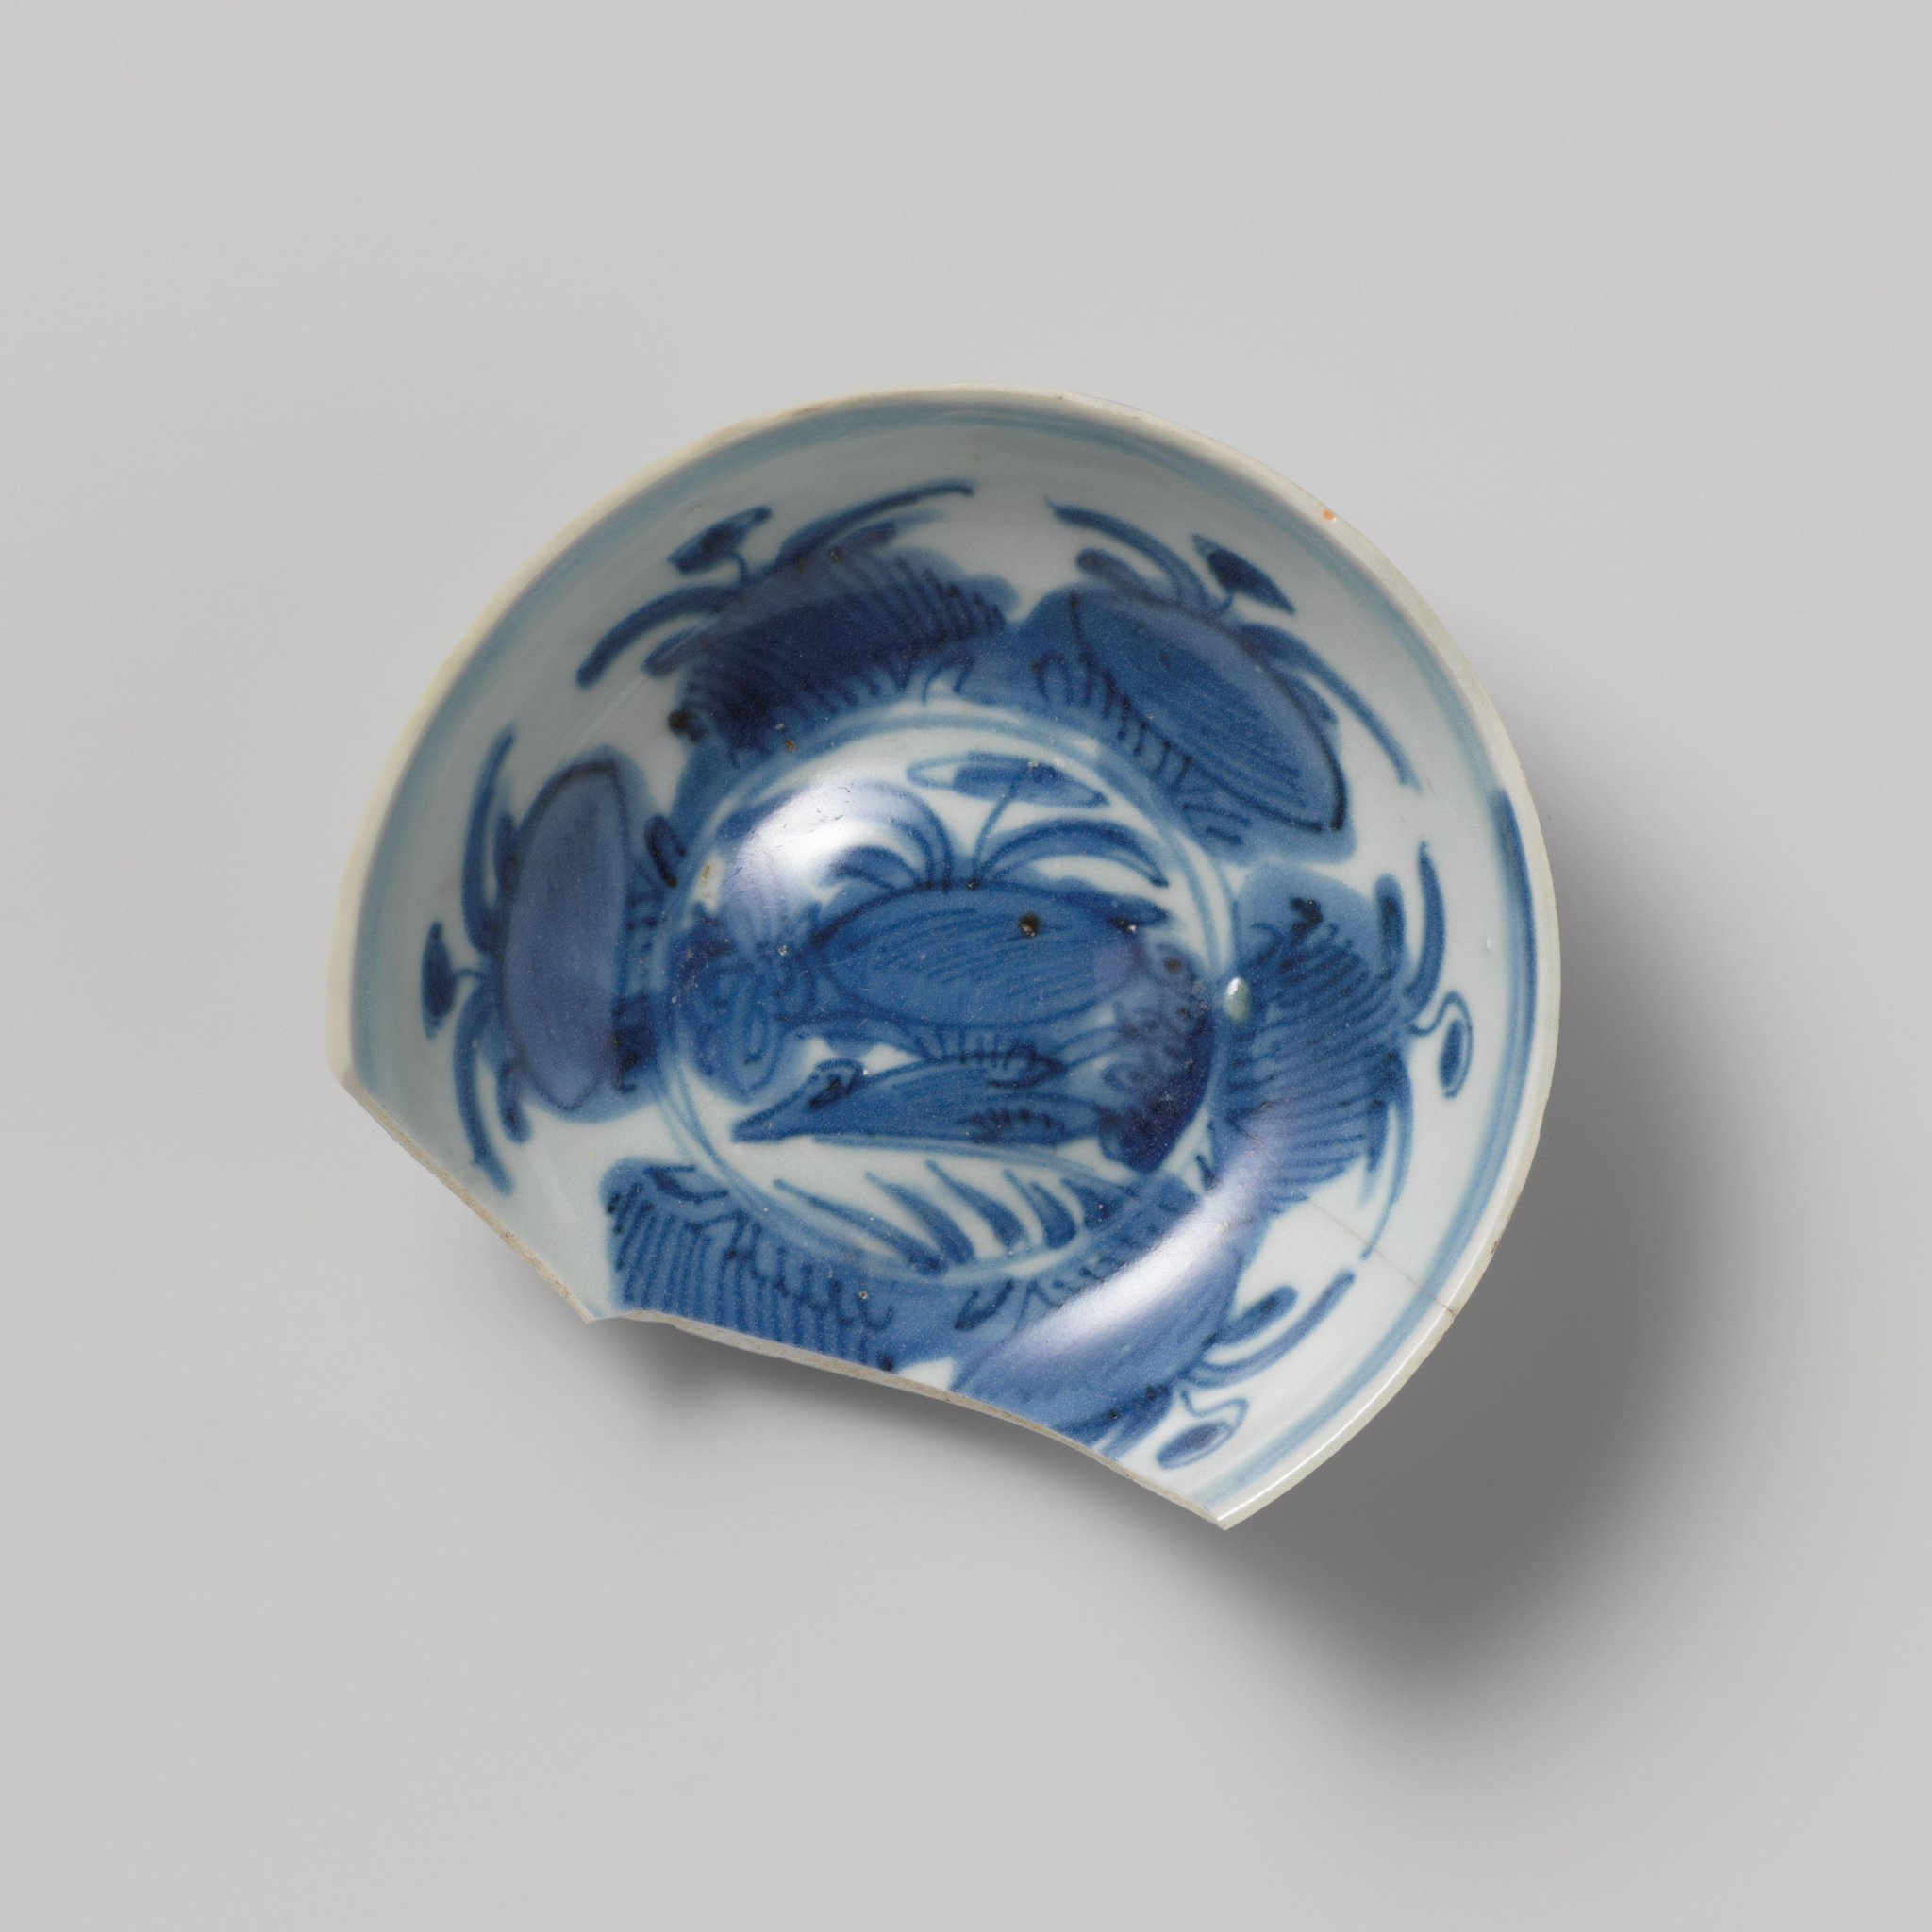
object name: platter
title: Fragment schotel uit V.O.C.-schip de 'Witte Leeuw'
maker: Anonymous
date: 1613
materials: porcelain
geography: jingdezhen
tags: verenigde oostindische compagnie, sint-helena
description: A saucer. The colour of the cobalt blue varies from grey to purple blue. The decoration on the inside consists of a flowering lotus plant with a duck underneath in the centre. On the cavetto 6 similar lotus plants are drawn.